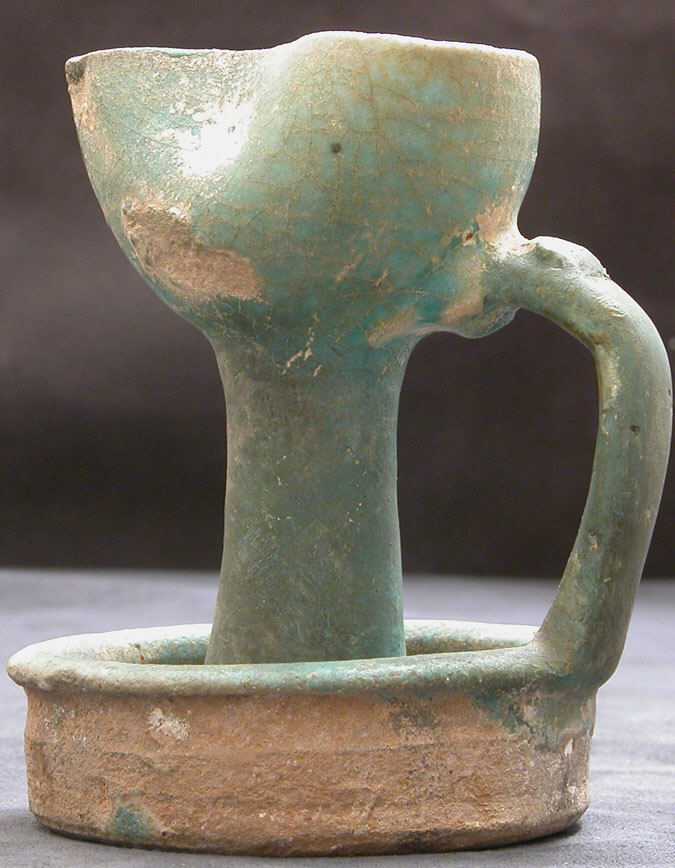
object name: lamp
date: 1201-1400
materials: earthenware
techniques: glazing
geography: syria